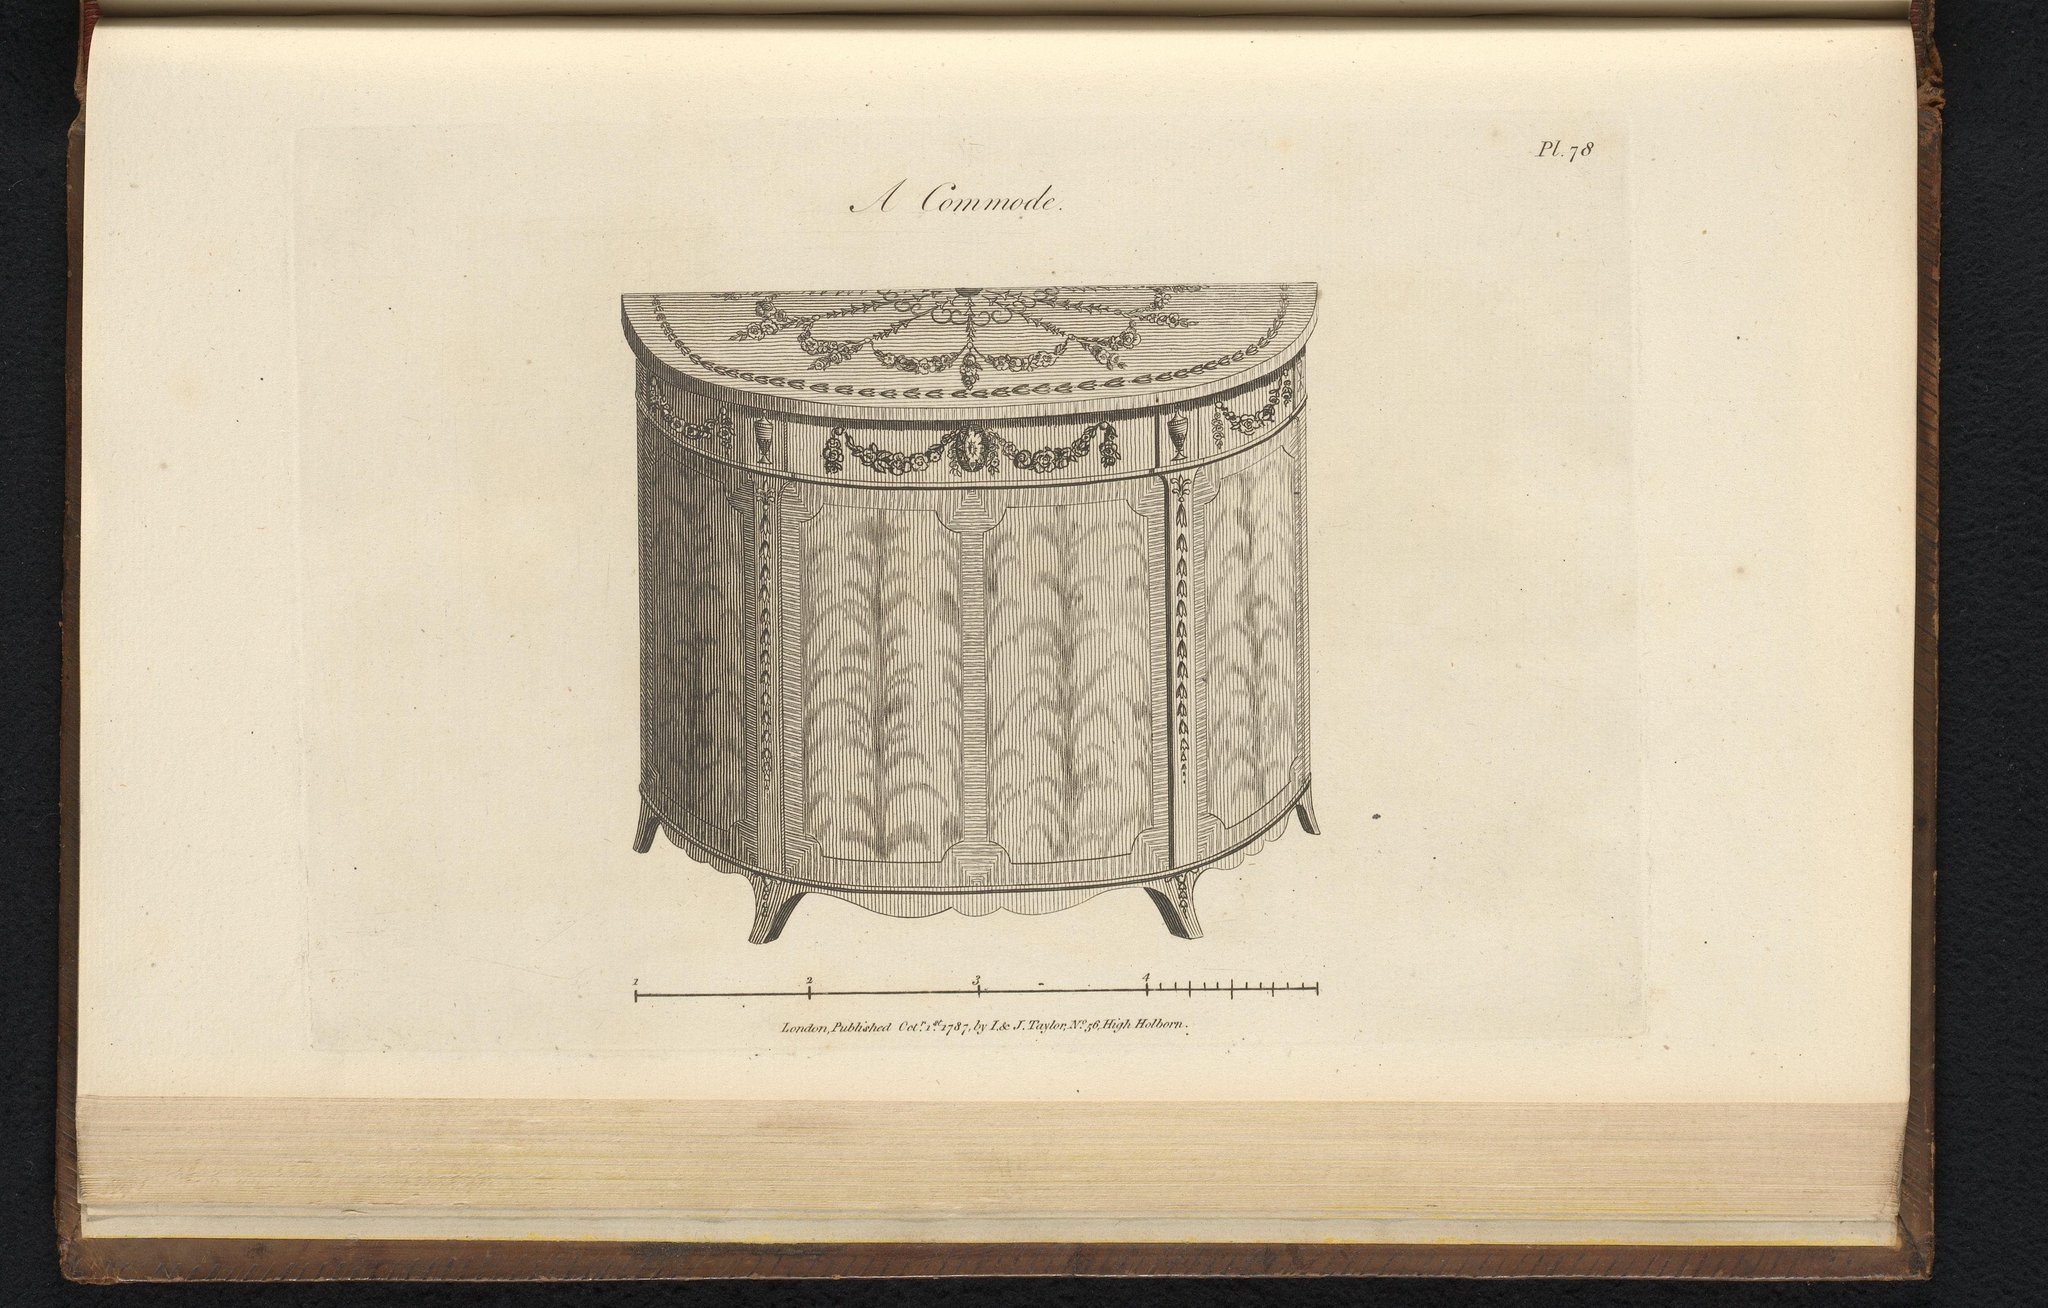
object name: page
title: Meubels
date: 1787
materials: paper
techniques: engraving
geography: holborn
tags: furniture for storage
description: Genummerd: Pl. 78. Schaalverdeling in de ondermarge. Prent maakt deel uit van een boek.